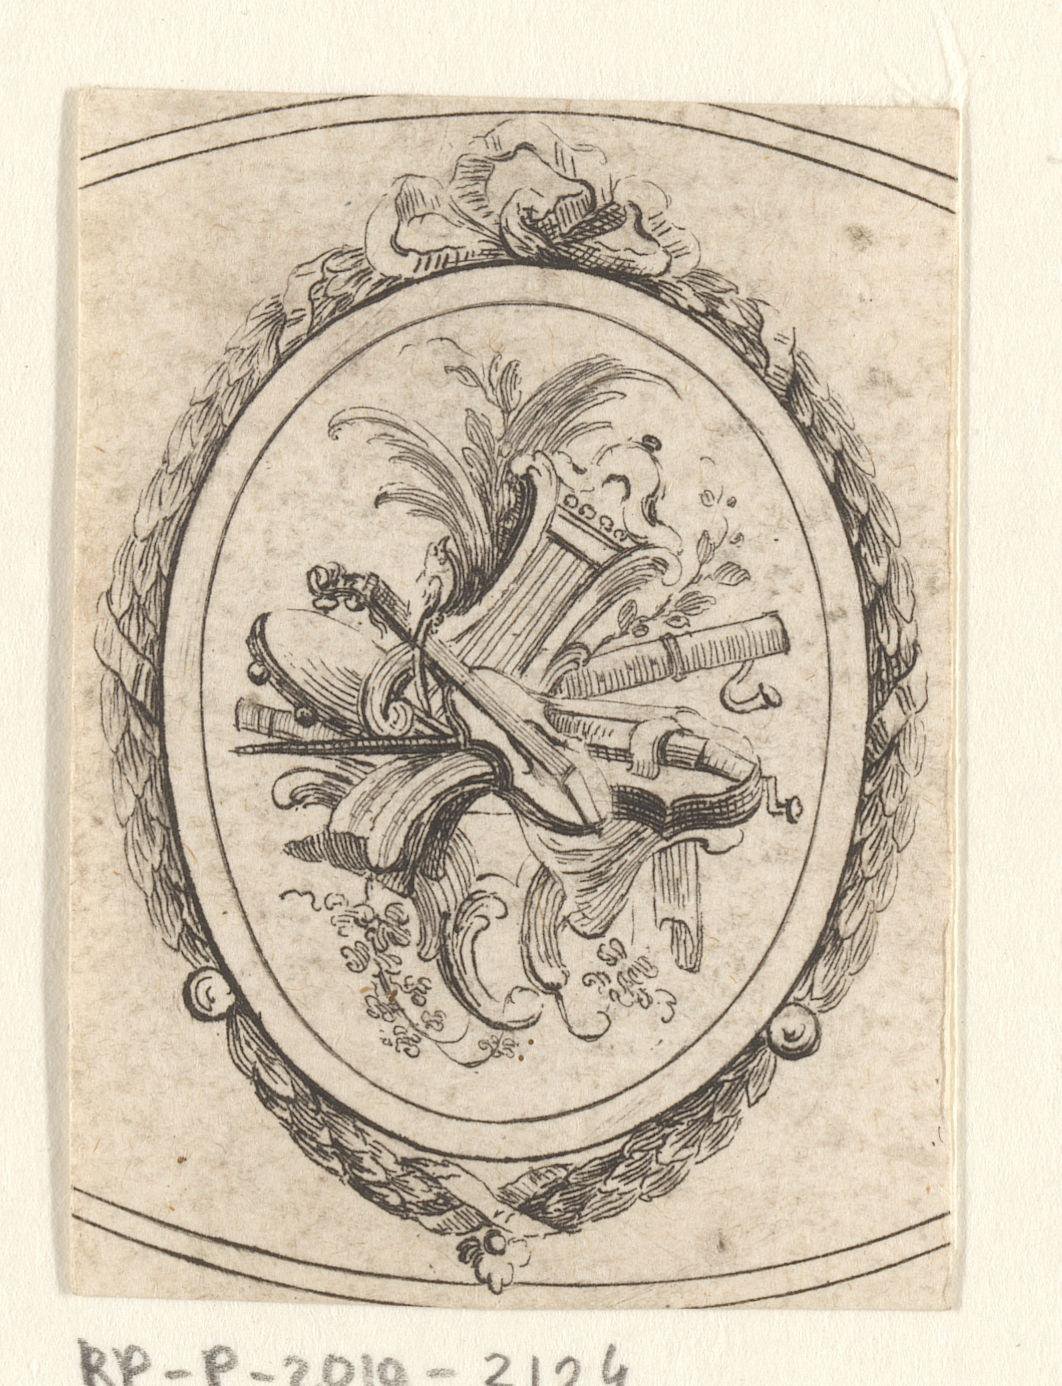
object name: print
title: Vignet met een cartouche met muziekinstrumenten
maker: Anonymous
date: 1650-1799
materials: paper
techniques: etching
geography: netherlands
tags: musical instruments; group of musical instruments, ornament ~ cartouche, illustration ~ printed matter, book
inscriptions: collector's mark: Lugt 2228